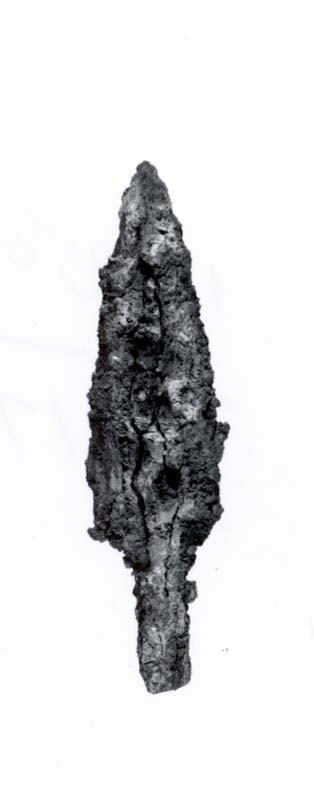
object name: arrowhead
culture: iranian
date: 900-801 BCE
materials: iron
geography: iran